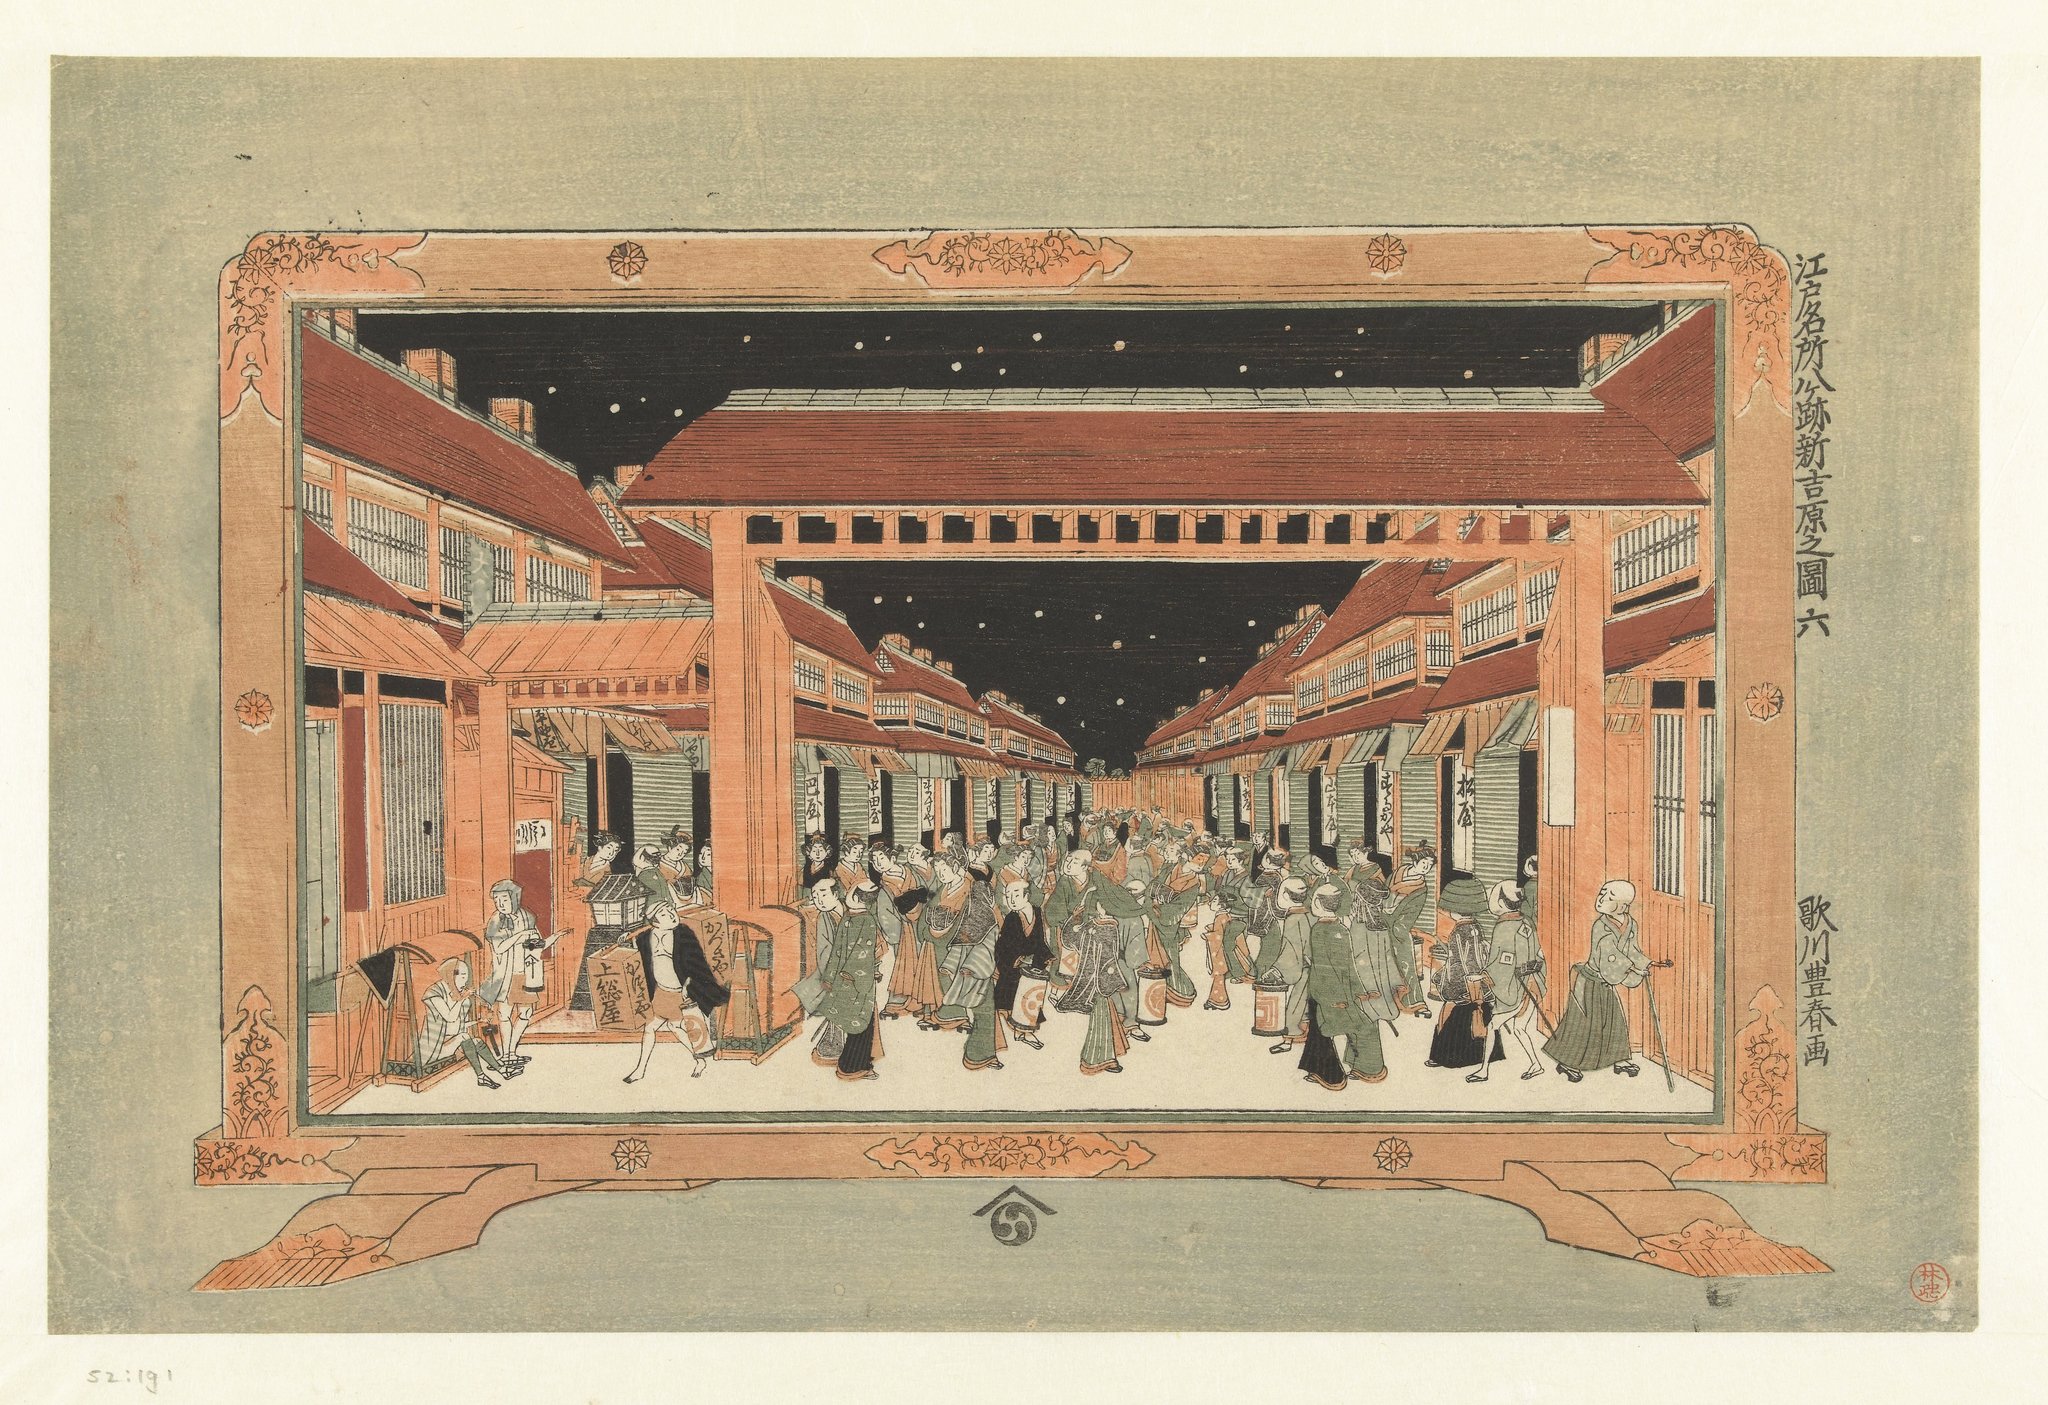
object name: print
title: Gezicht op het Nieuwe Yoshiwara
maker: utagawa toyoharu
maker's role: print maker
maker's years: 1735-1814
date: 1770-1775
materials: paper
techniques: woodcut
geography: japan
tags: gate, entrance, screen, folding screen, street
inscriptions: collector's mark: Lugt 2971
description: Kamerscherm waarop afbeelding van een gezicht op de toegangspoort van het Yoshiwara met daarachter de hoofdstraat, Nakanocho, vol met mensen met lantaarns in de hand; bij nacht.